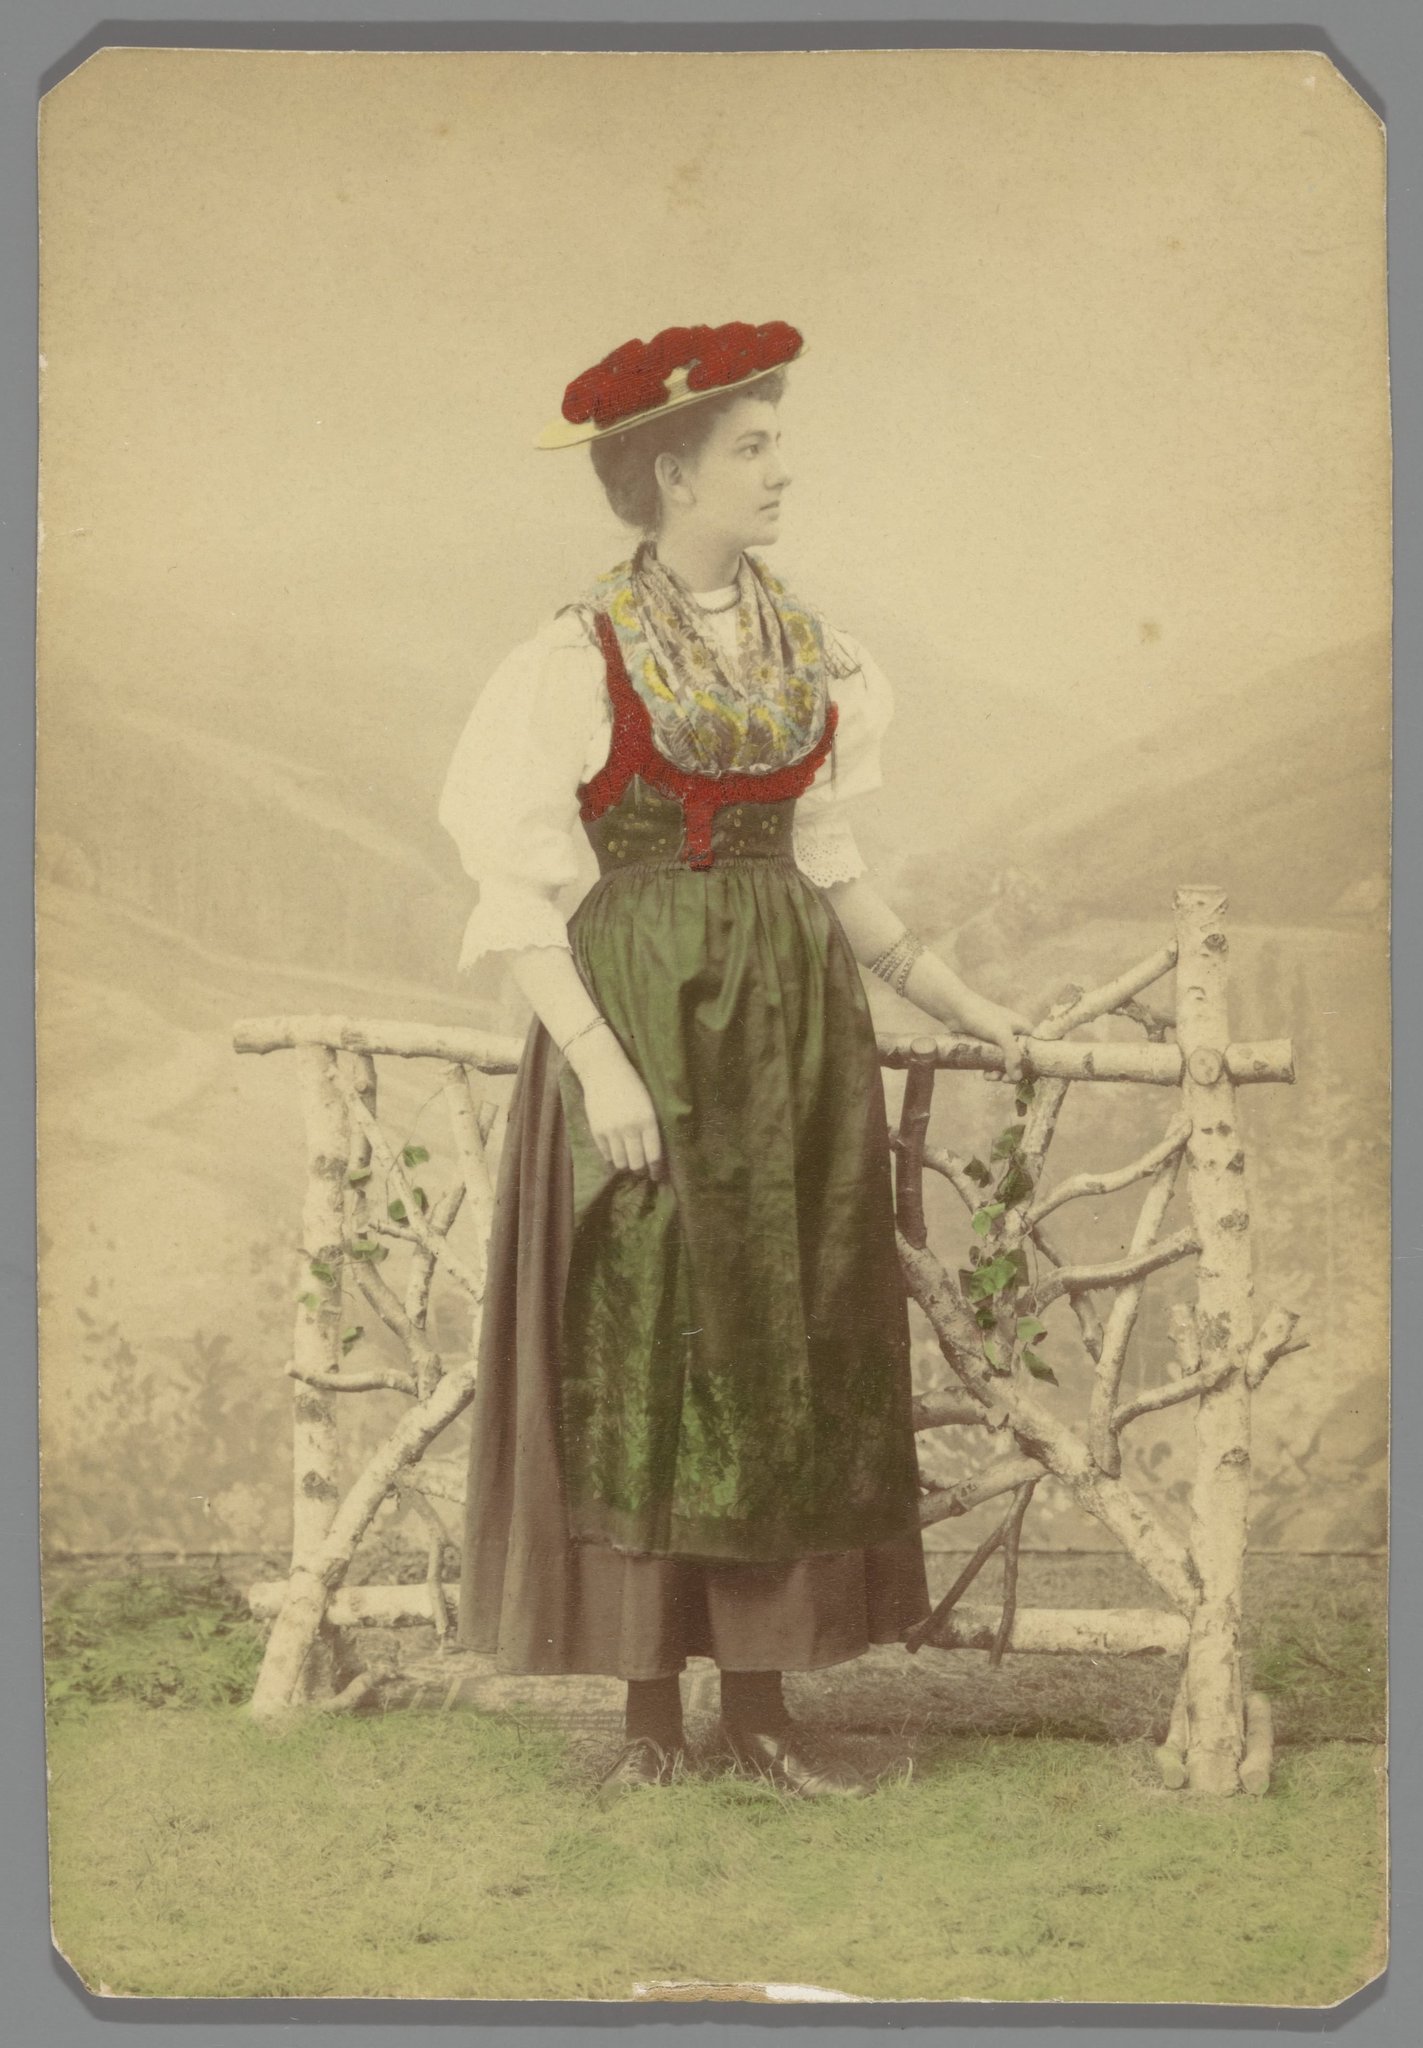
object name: photograph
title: Portret van Ida van Braam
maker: Anonymous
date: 1895-1920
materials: photographic support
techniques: albumen print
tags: historical persons - bb - woman